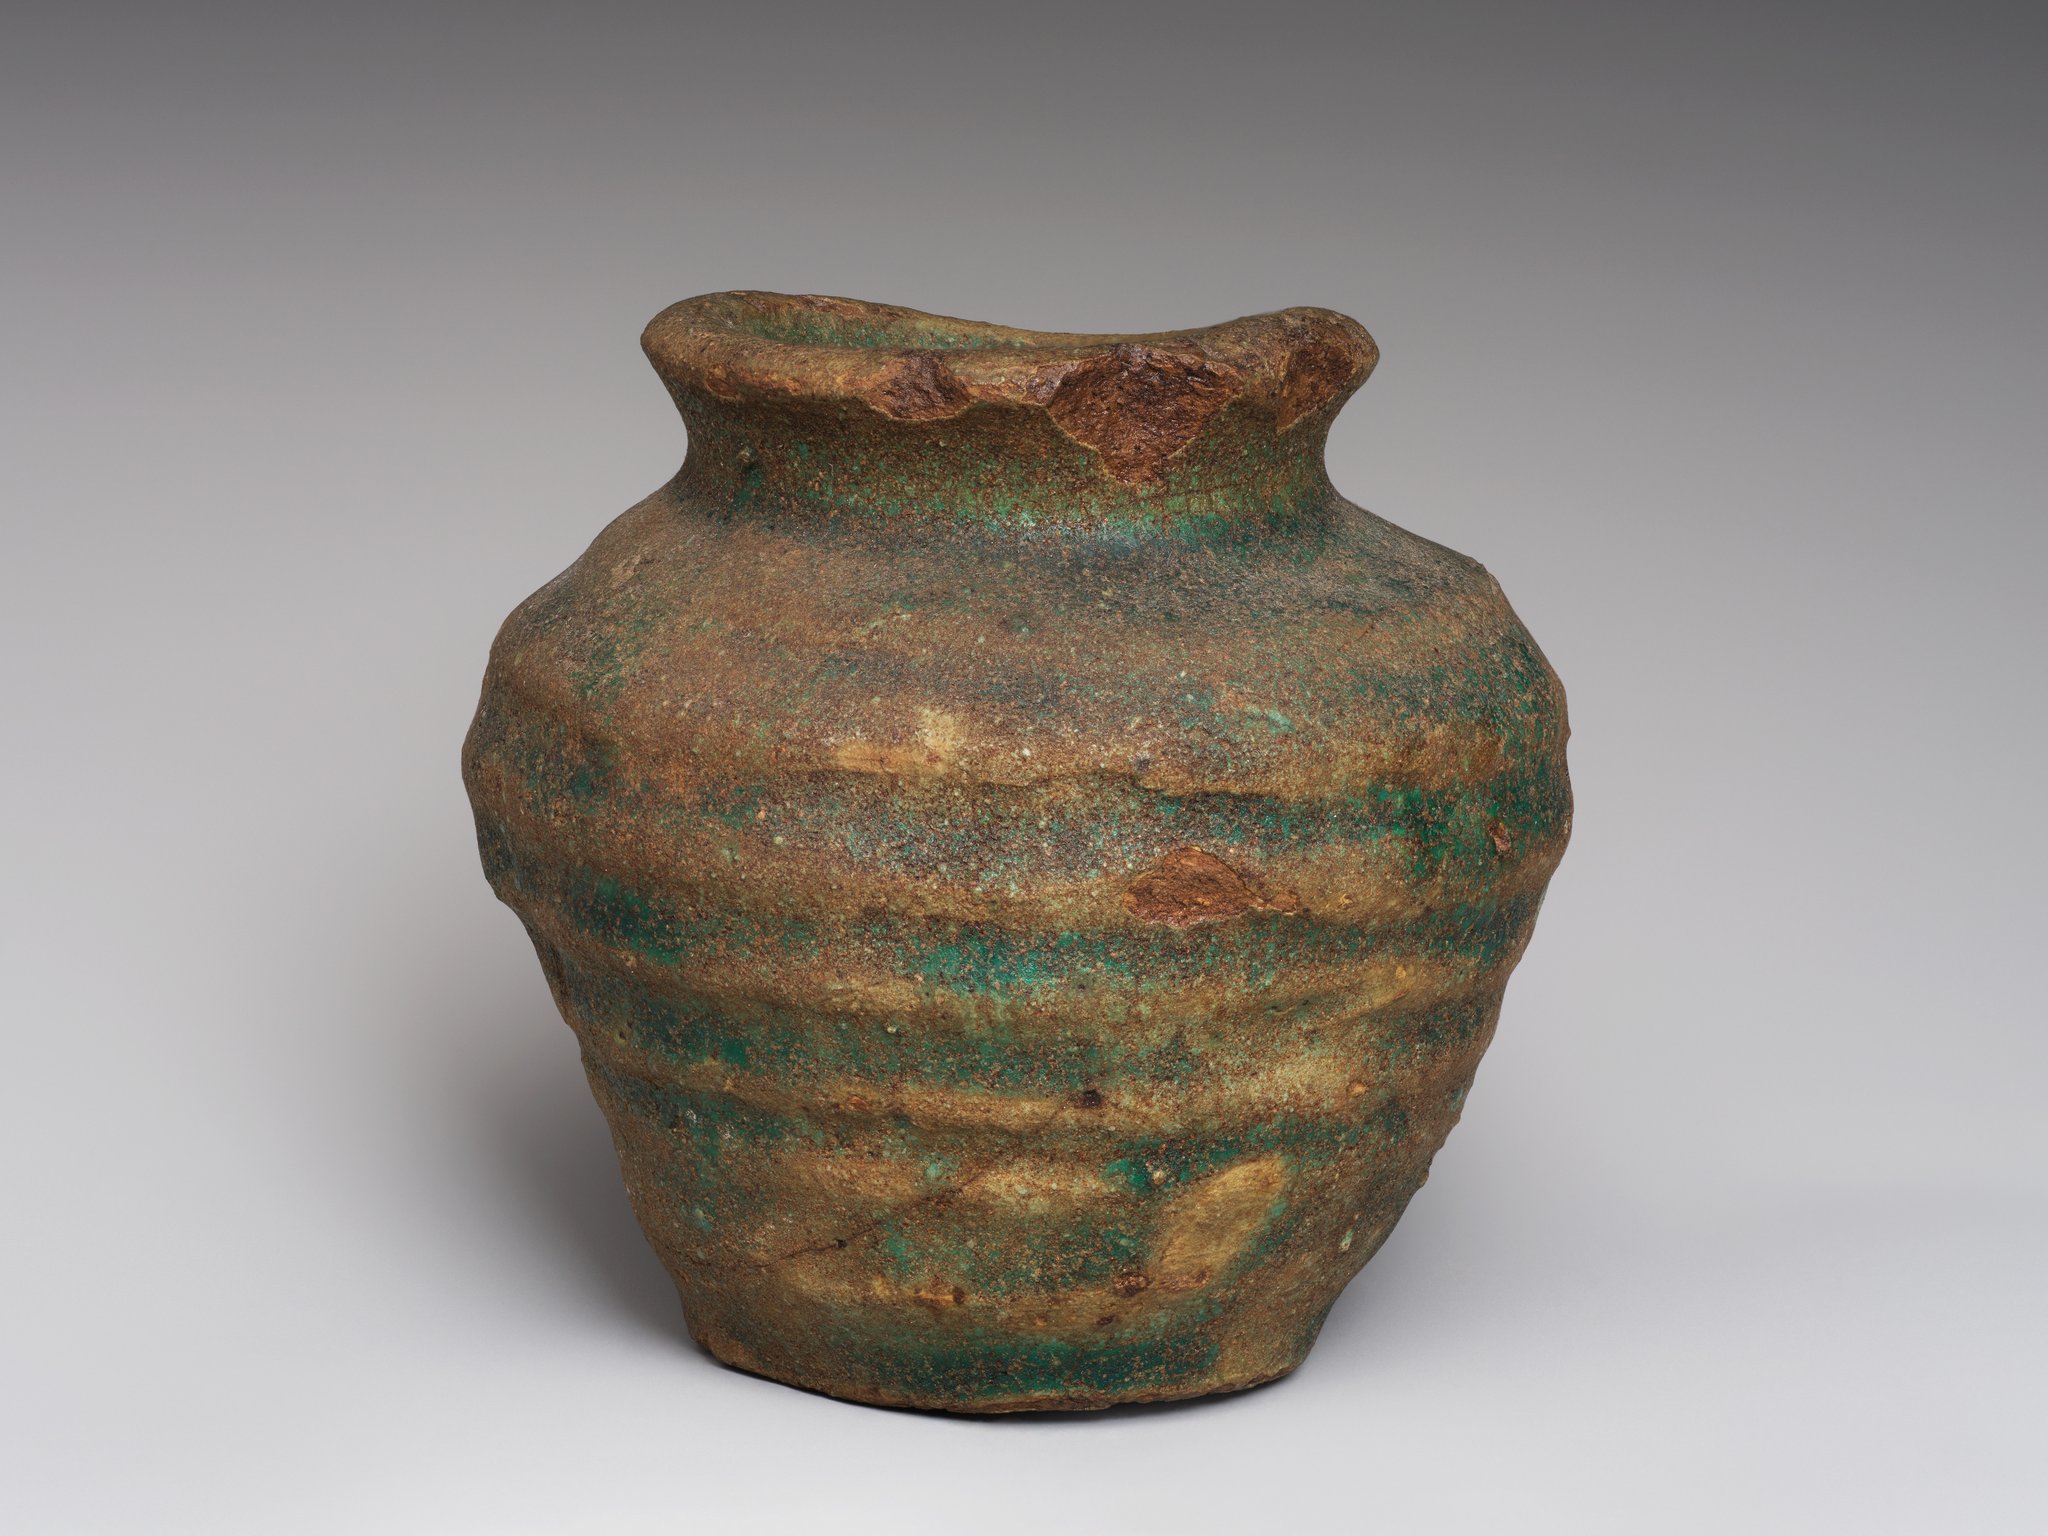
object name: pot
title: Small pot with remnants of green glaze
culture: sasanian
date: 201-700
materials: ceramic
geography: mesopotamia